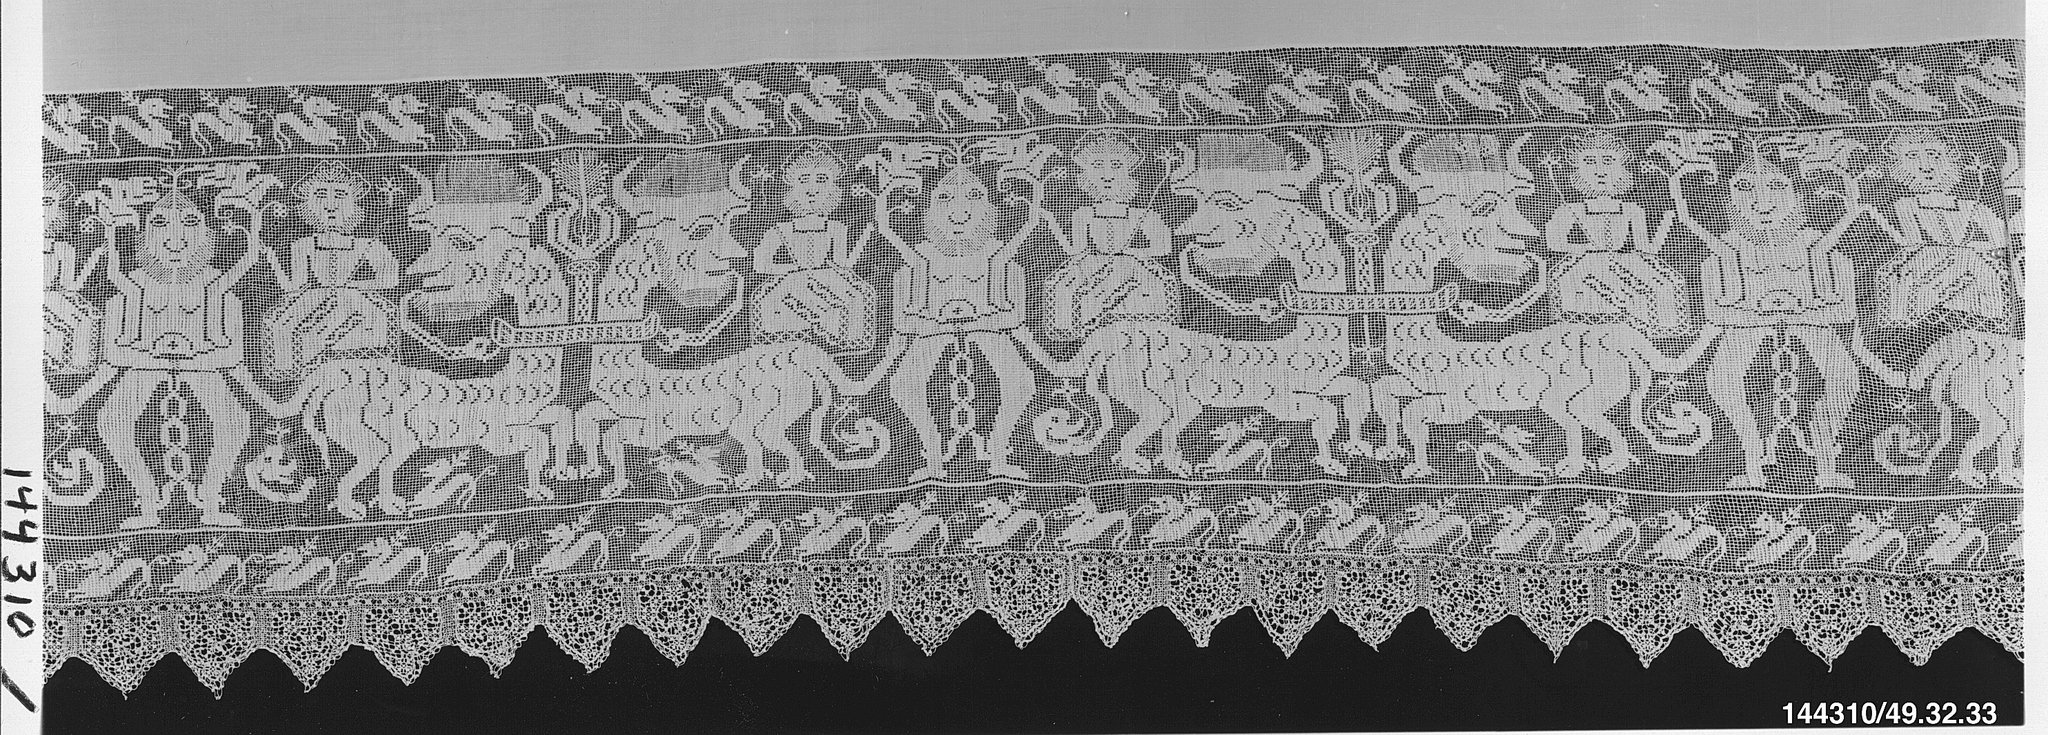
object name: altar frontal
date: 1601-1633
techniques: embroidery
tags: men,women,mythical creatures